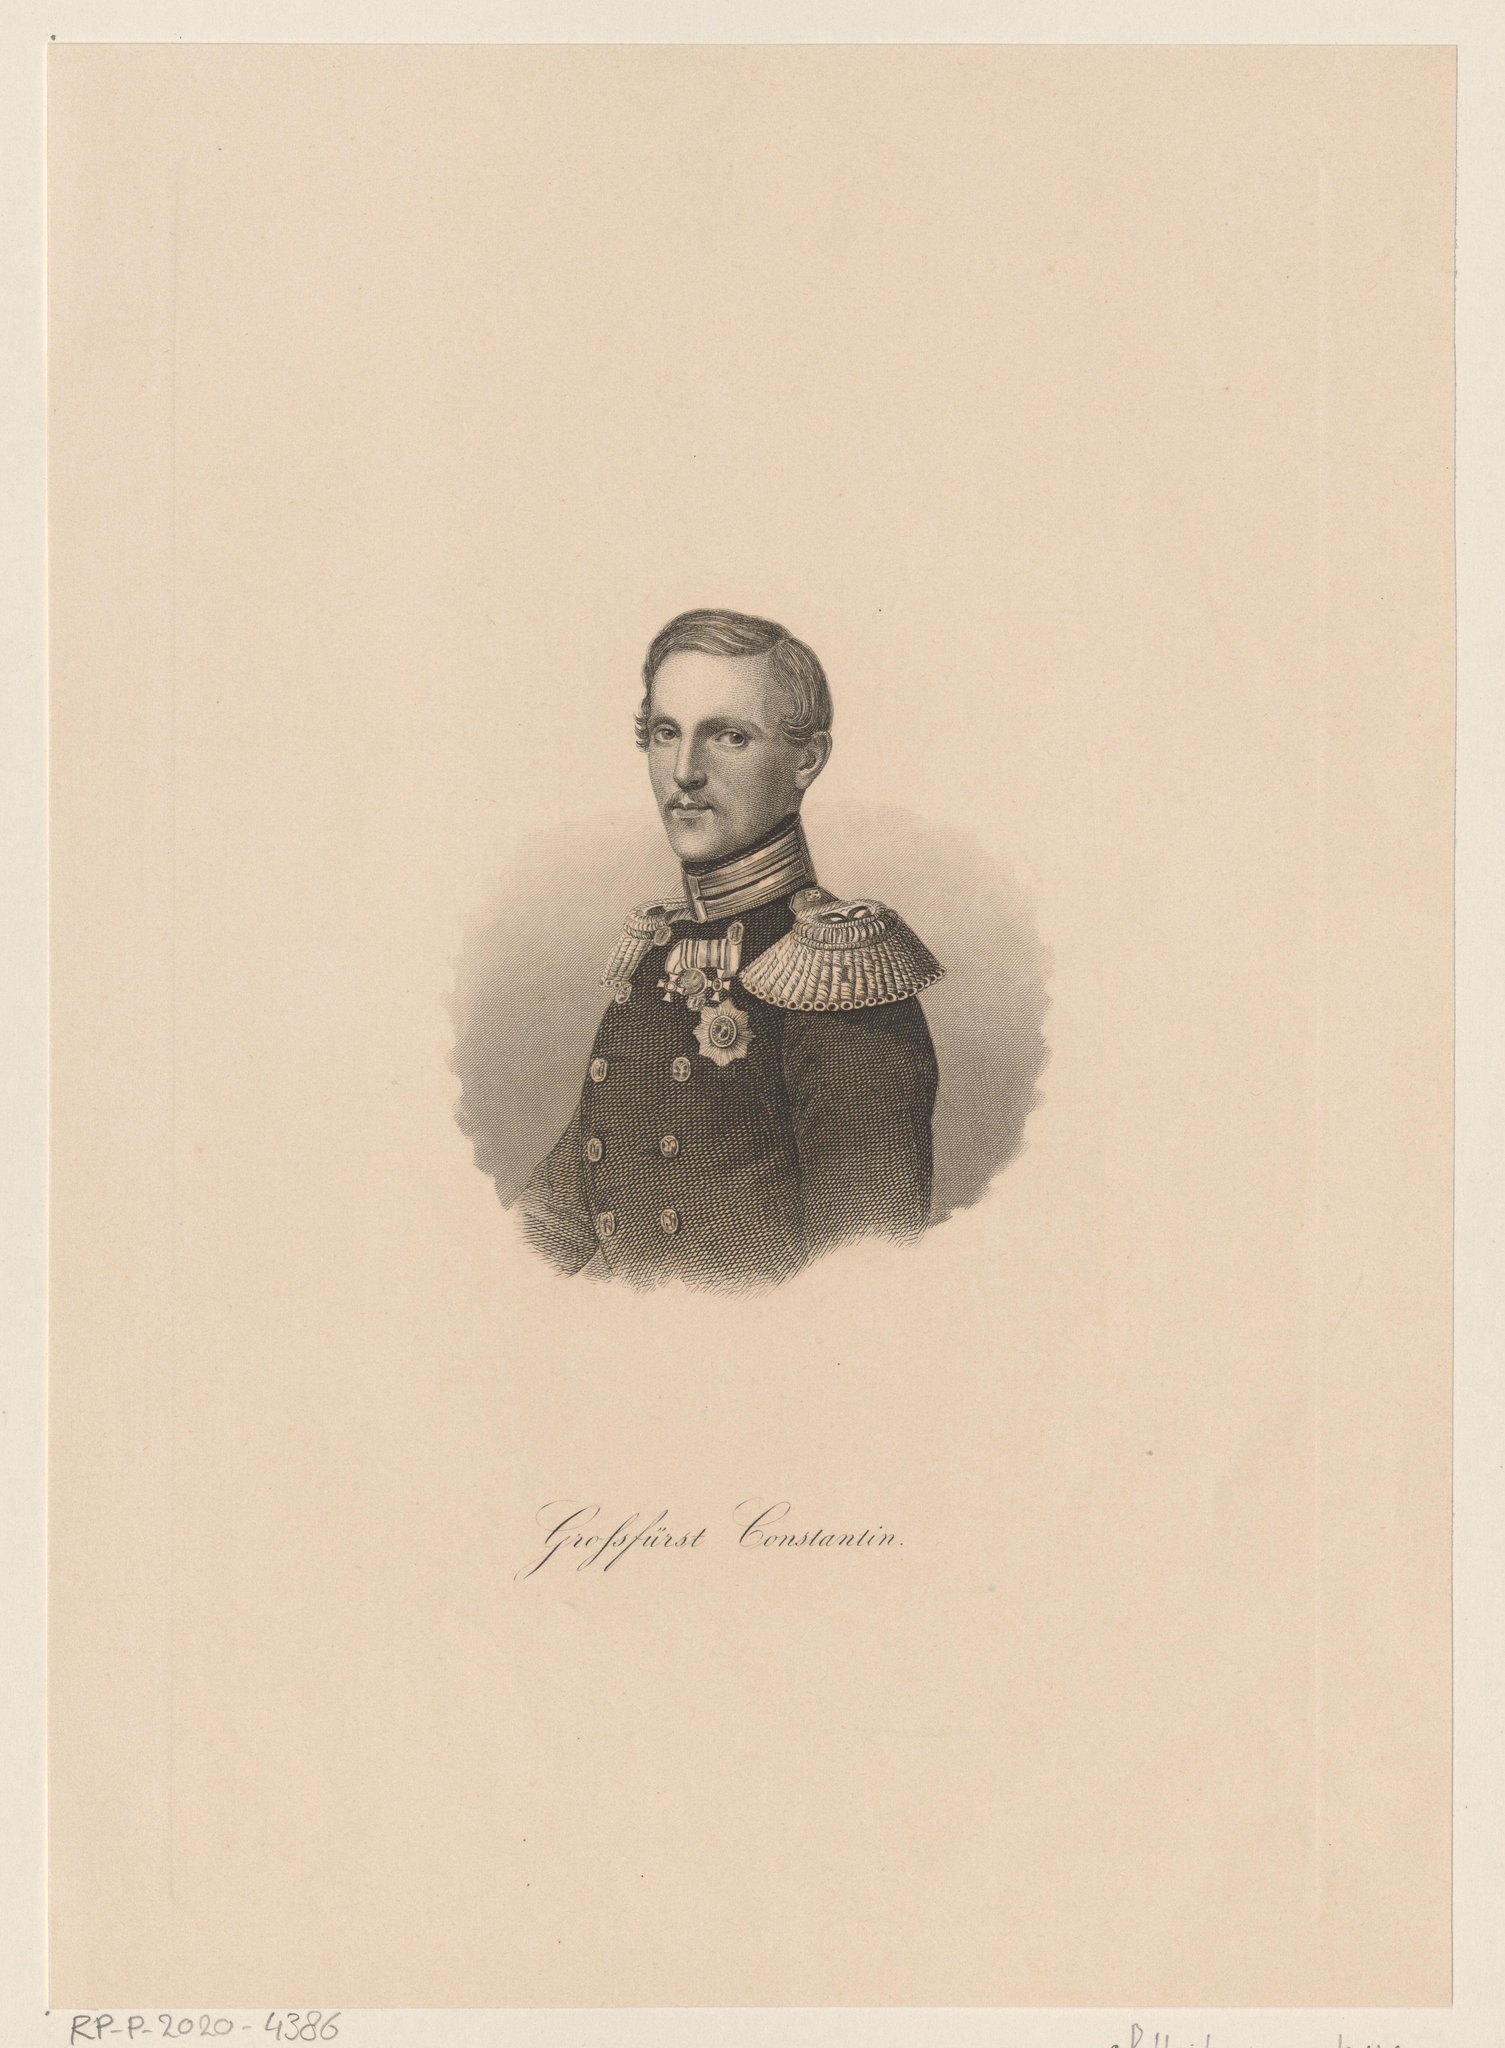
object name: print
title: Portret van Constantijn Pavlovitsj van Rusland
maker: Anonymous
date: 1800-1899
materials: paper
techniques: etching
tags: historical persons, ruler, sovereign